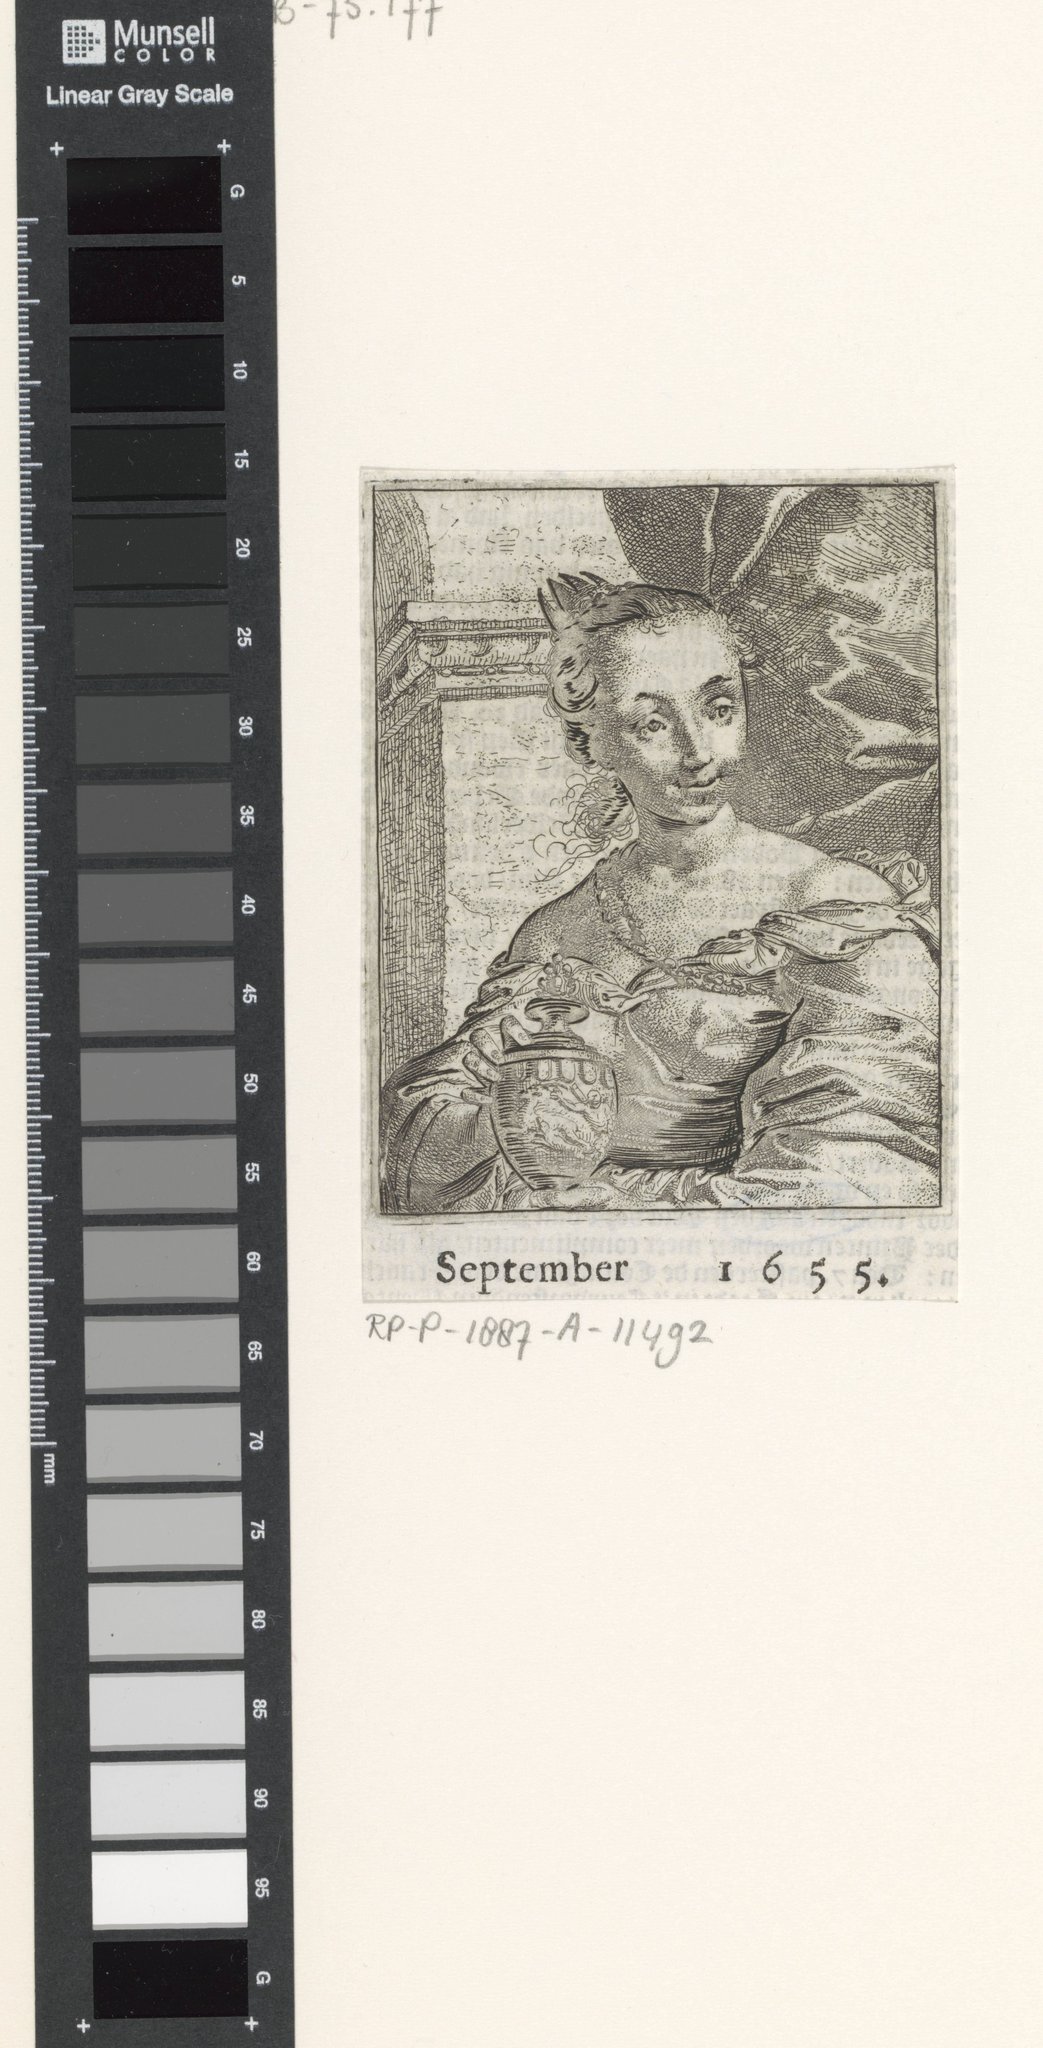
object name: print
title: Sophonisba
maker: Anonymous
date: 1655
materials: paper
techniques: engraving, etching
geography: netherlands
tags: (story of) sophonisbe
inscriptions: collector's mark: Lugt 2228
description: Sophonisba met de gifbeker in haar handen. Op haar hoofd een kroon.